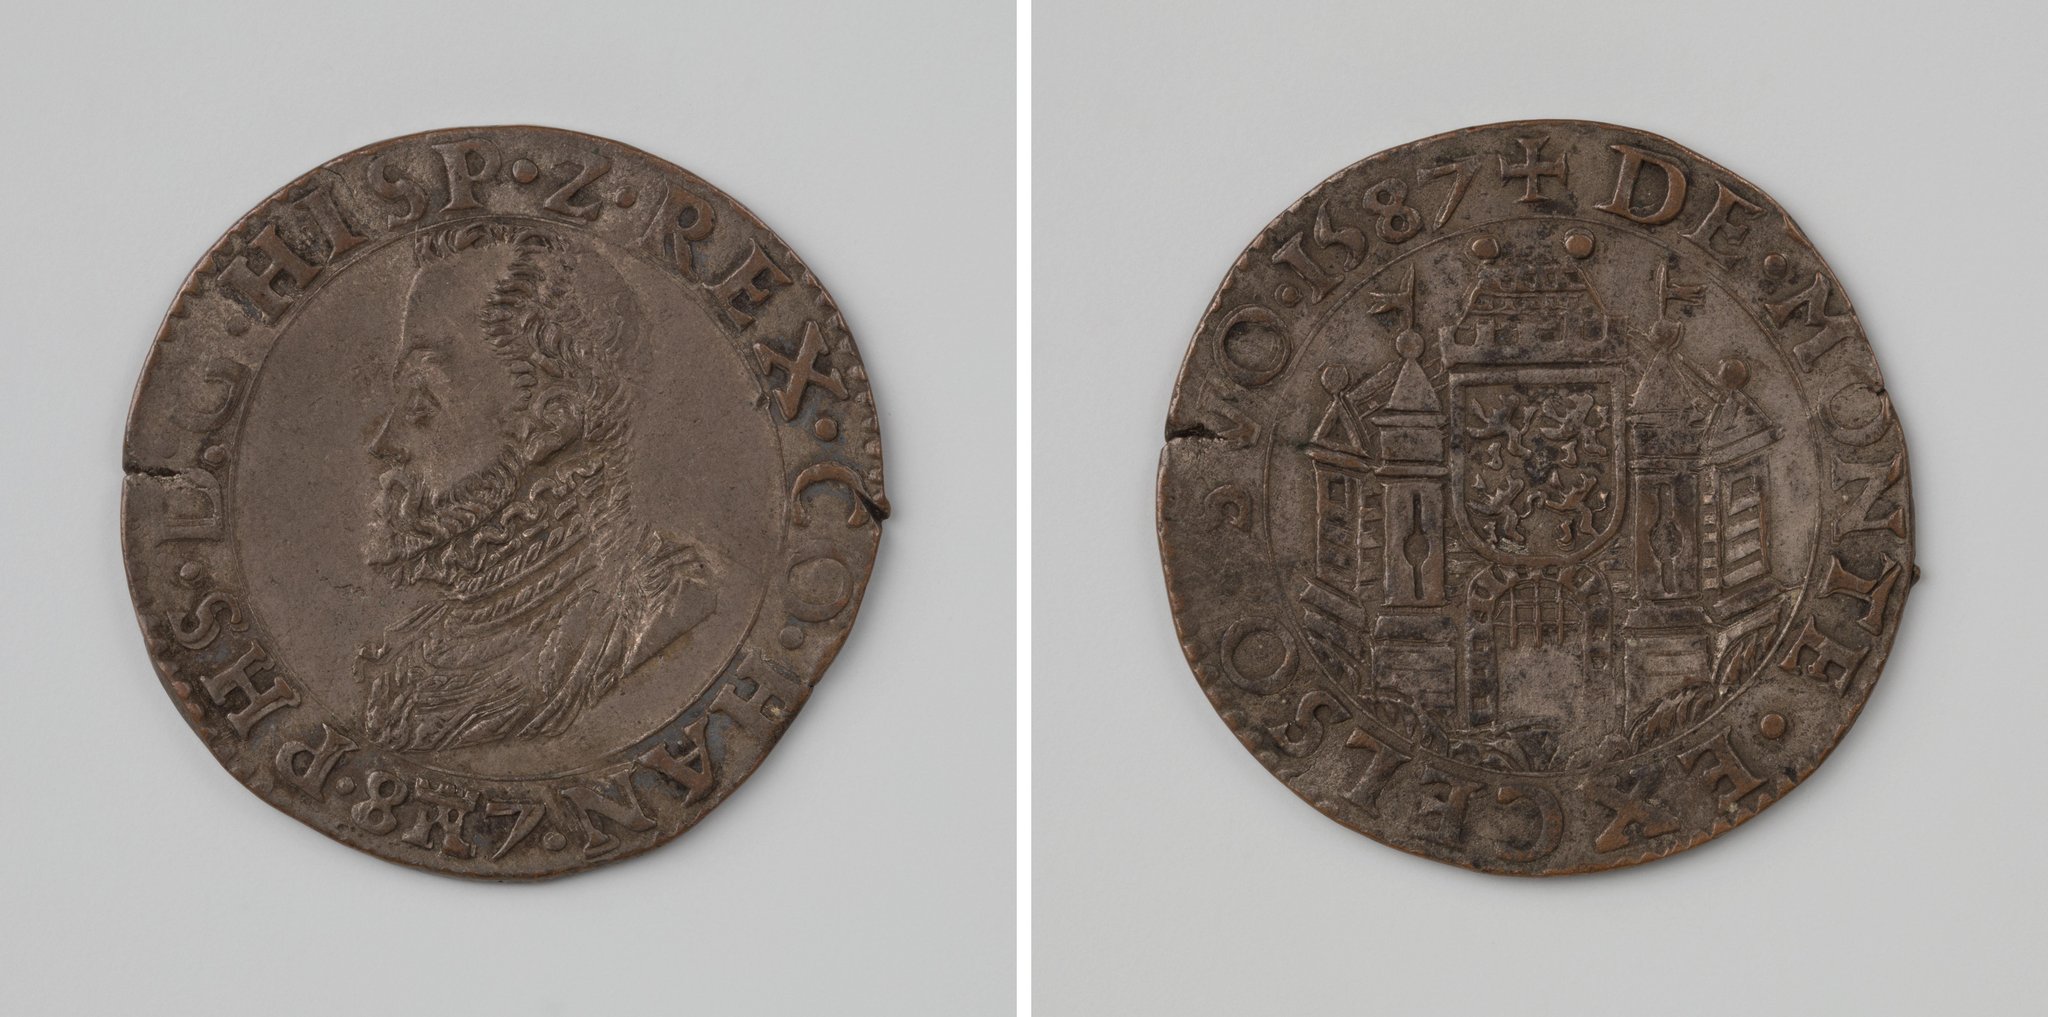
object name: jeton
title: Filips II, koning van Spanje, graaf van Henegouwen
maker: Anonymous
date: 1587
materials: silver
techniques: striking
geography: belgium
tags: philip ii of spain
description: Zilveren penning. Voorzijde: borststuk man binnen omschrift. Keerzijde: kasteel met gekroond wapenschild boven poort binnen omschrift